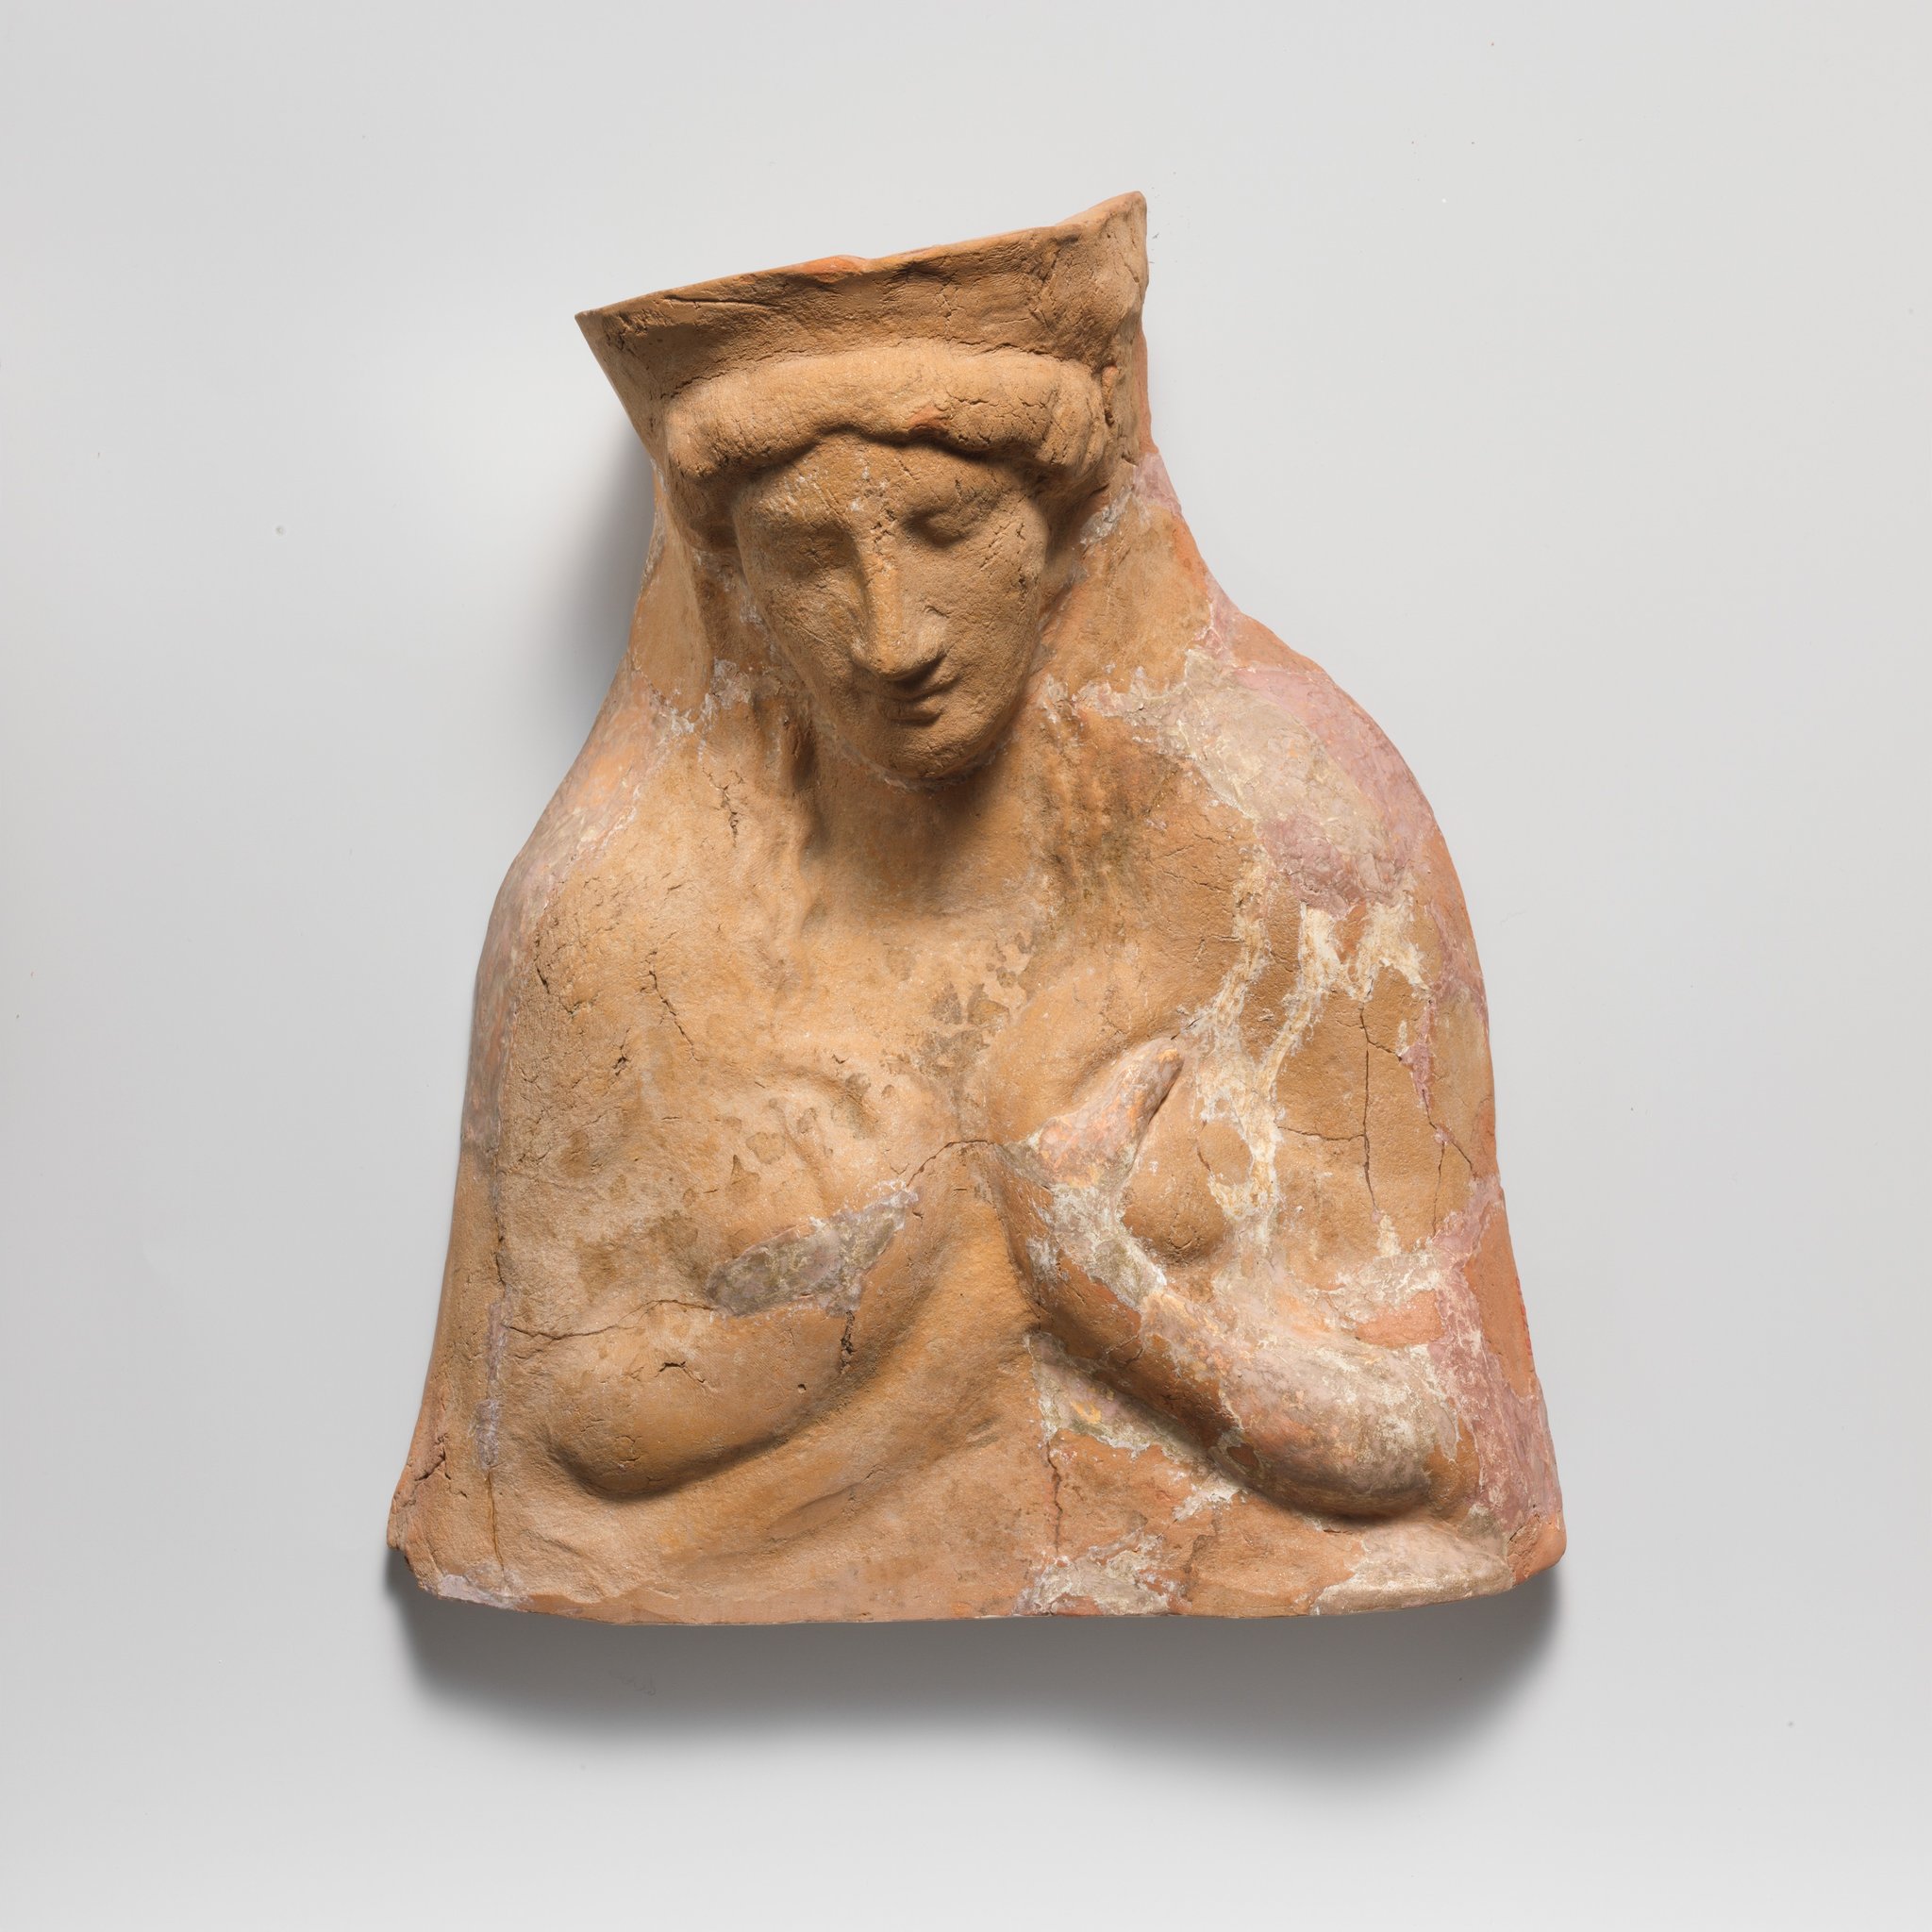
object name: bust of a woman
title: Terracotta relief with bust of a woman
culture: east greek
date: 400 BCE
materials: terracotta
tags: women